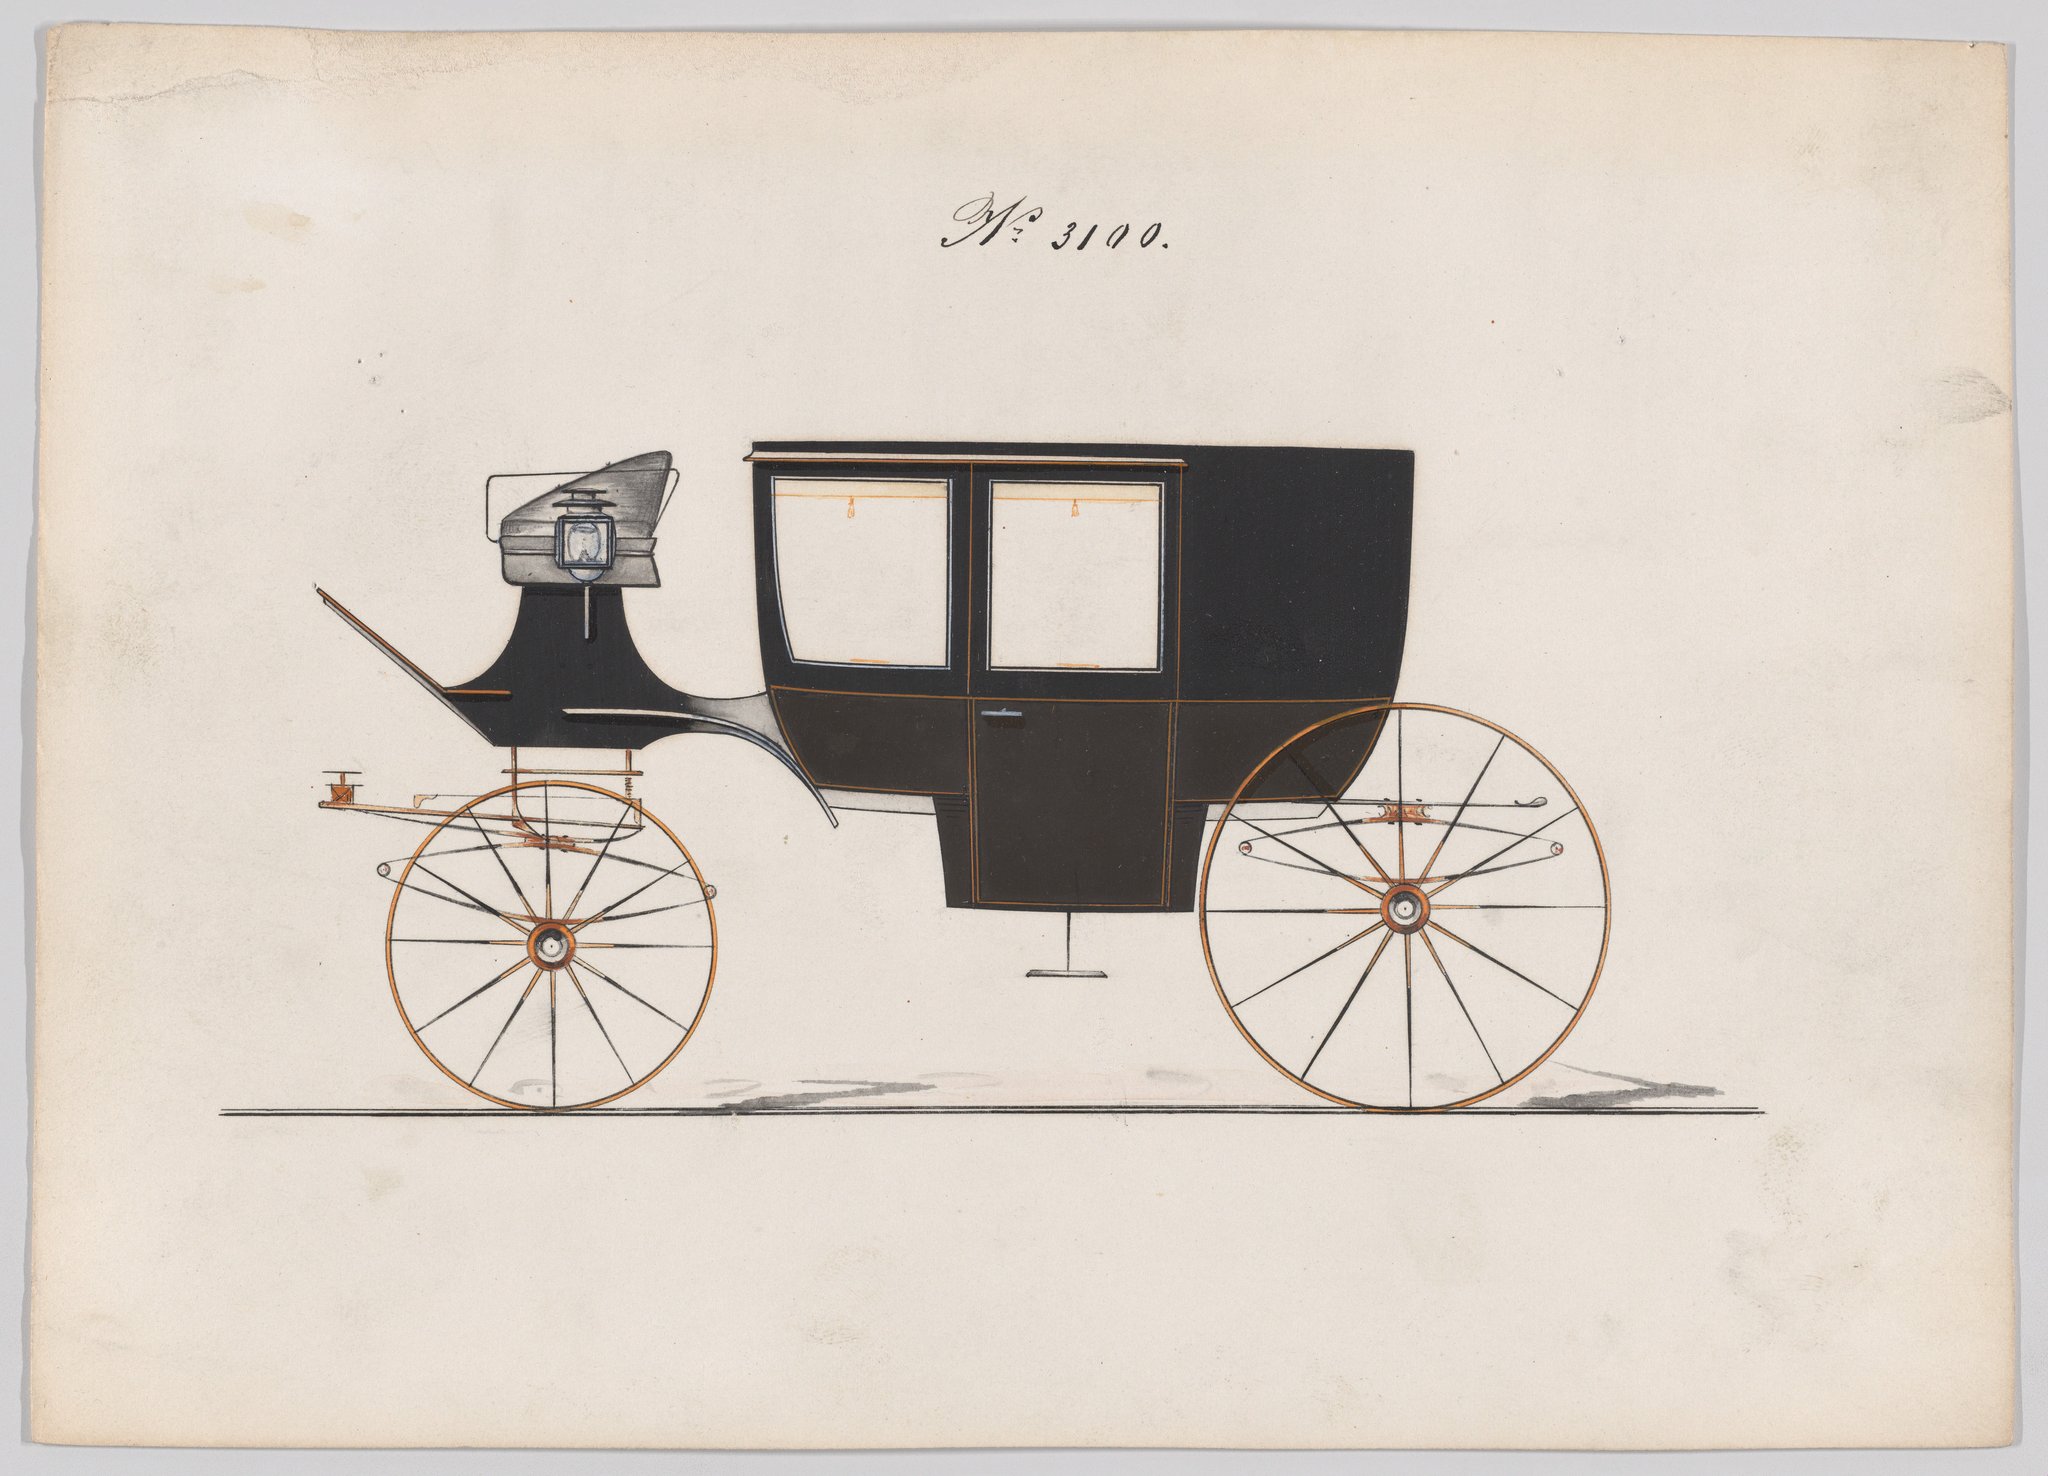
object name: drawing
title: Coach #3100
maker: brewster & co.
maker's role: manufacturer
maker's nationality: american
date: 1875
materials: gouache, gum arabic, ink, watercolor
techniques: pen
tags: carriages